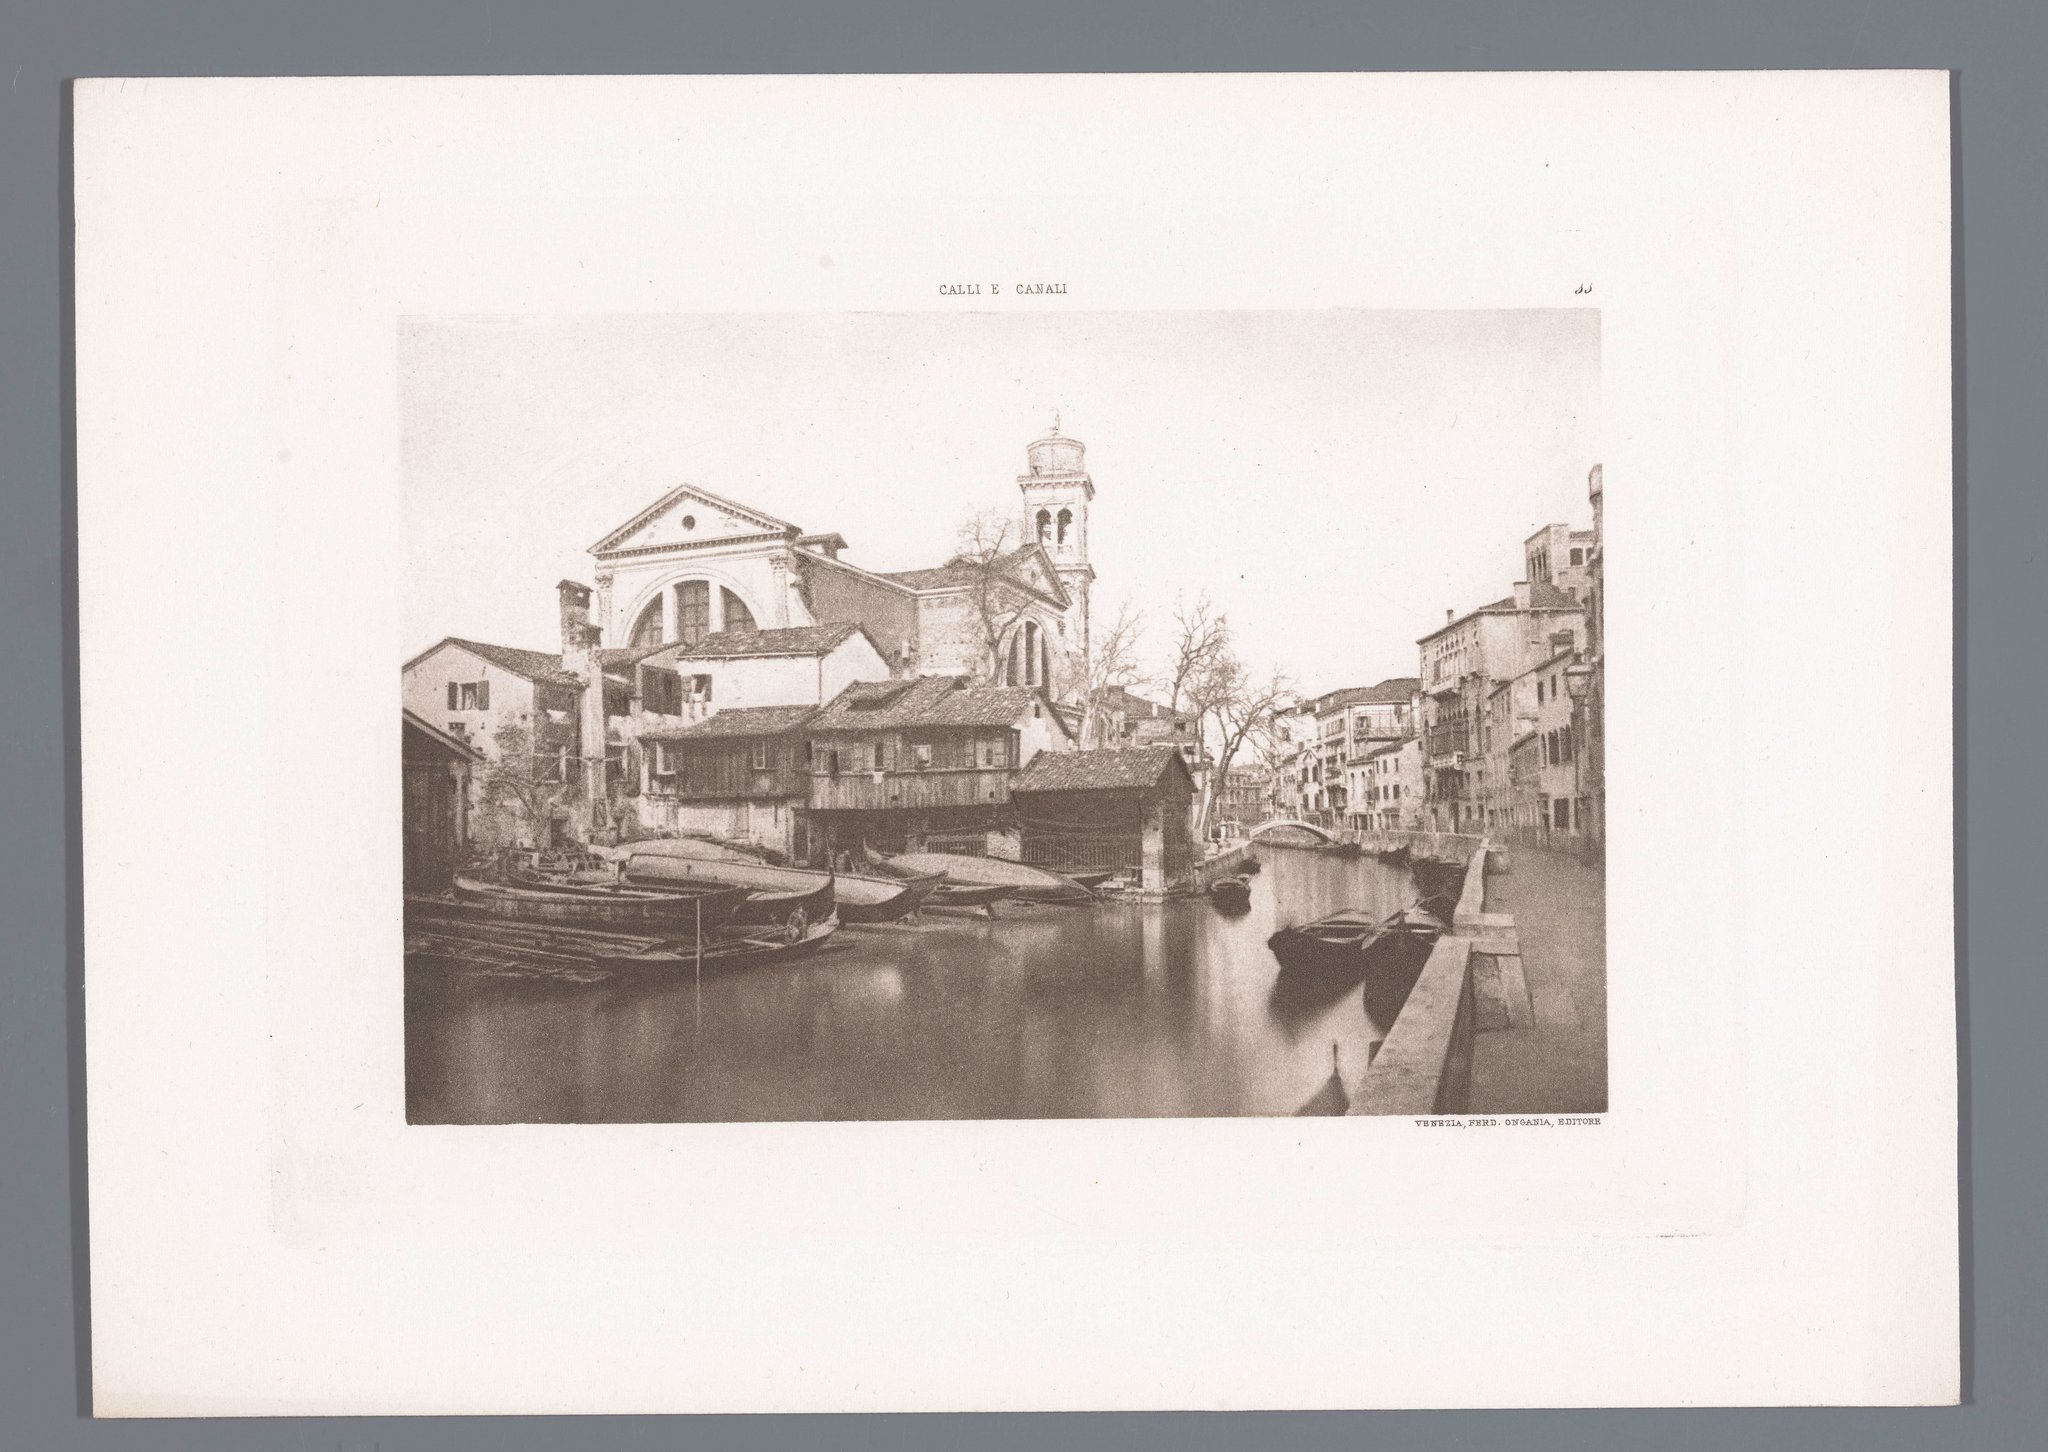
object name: page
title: Gezicht op een gondelwerkplaats aan het Squero di San Trovaso in Venetië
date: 1888-1898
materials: paper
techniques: photoaquatint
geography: venice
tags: gondola, venice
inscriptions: inscription: ‘ss’